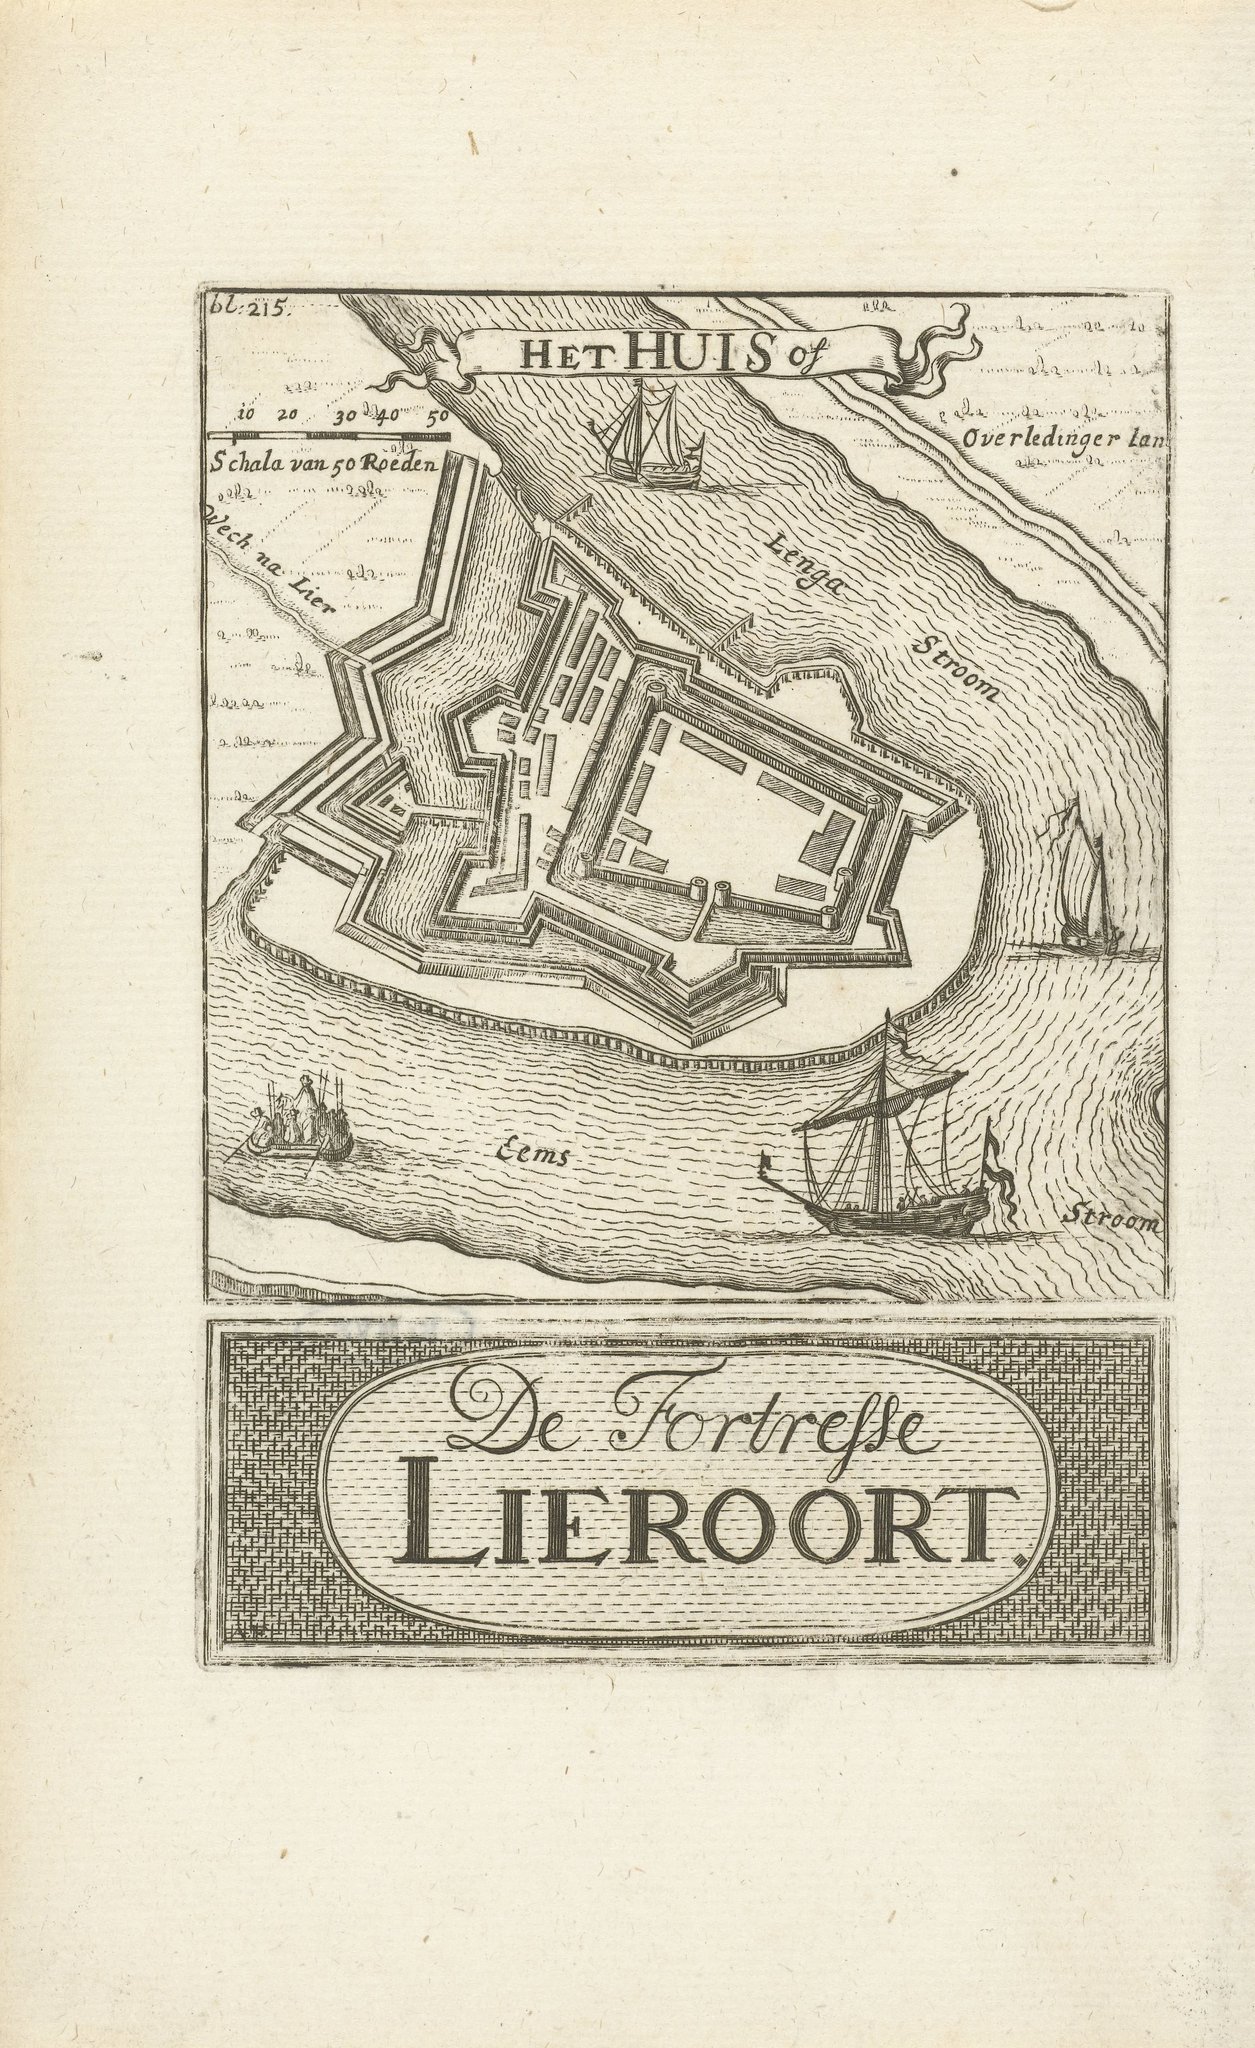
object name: book illustration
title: Kaart van de vesting Lierort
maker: hendrik hofsnider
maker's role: print maker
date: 1743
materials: paper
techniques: etching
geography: groningen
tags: maps, atlases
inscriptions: collector's mark: Lugt 2760, collector's mark: Lugt 2228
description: Twee afdrukken op één blad: Bovenaan een afdruk met een voorstelling van de vesting Lierort en daaronder een afdruk met de titel in een cartouche. In de bovenste afdruk bovenaan een deel van de titel op een lint, linksboven een schaal en: bl. 215.